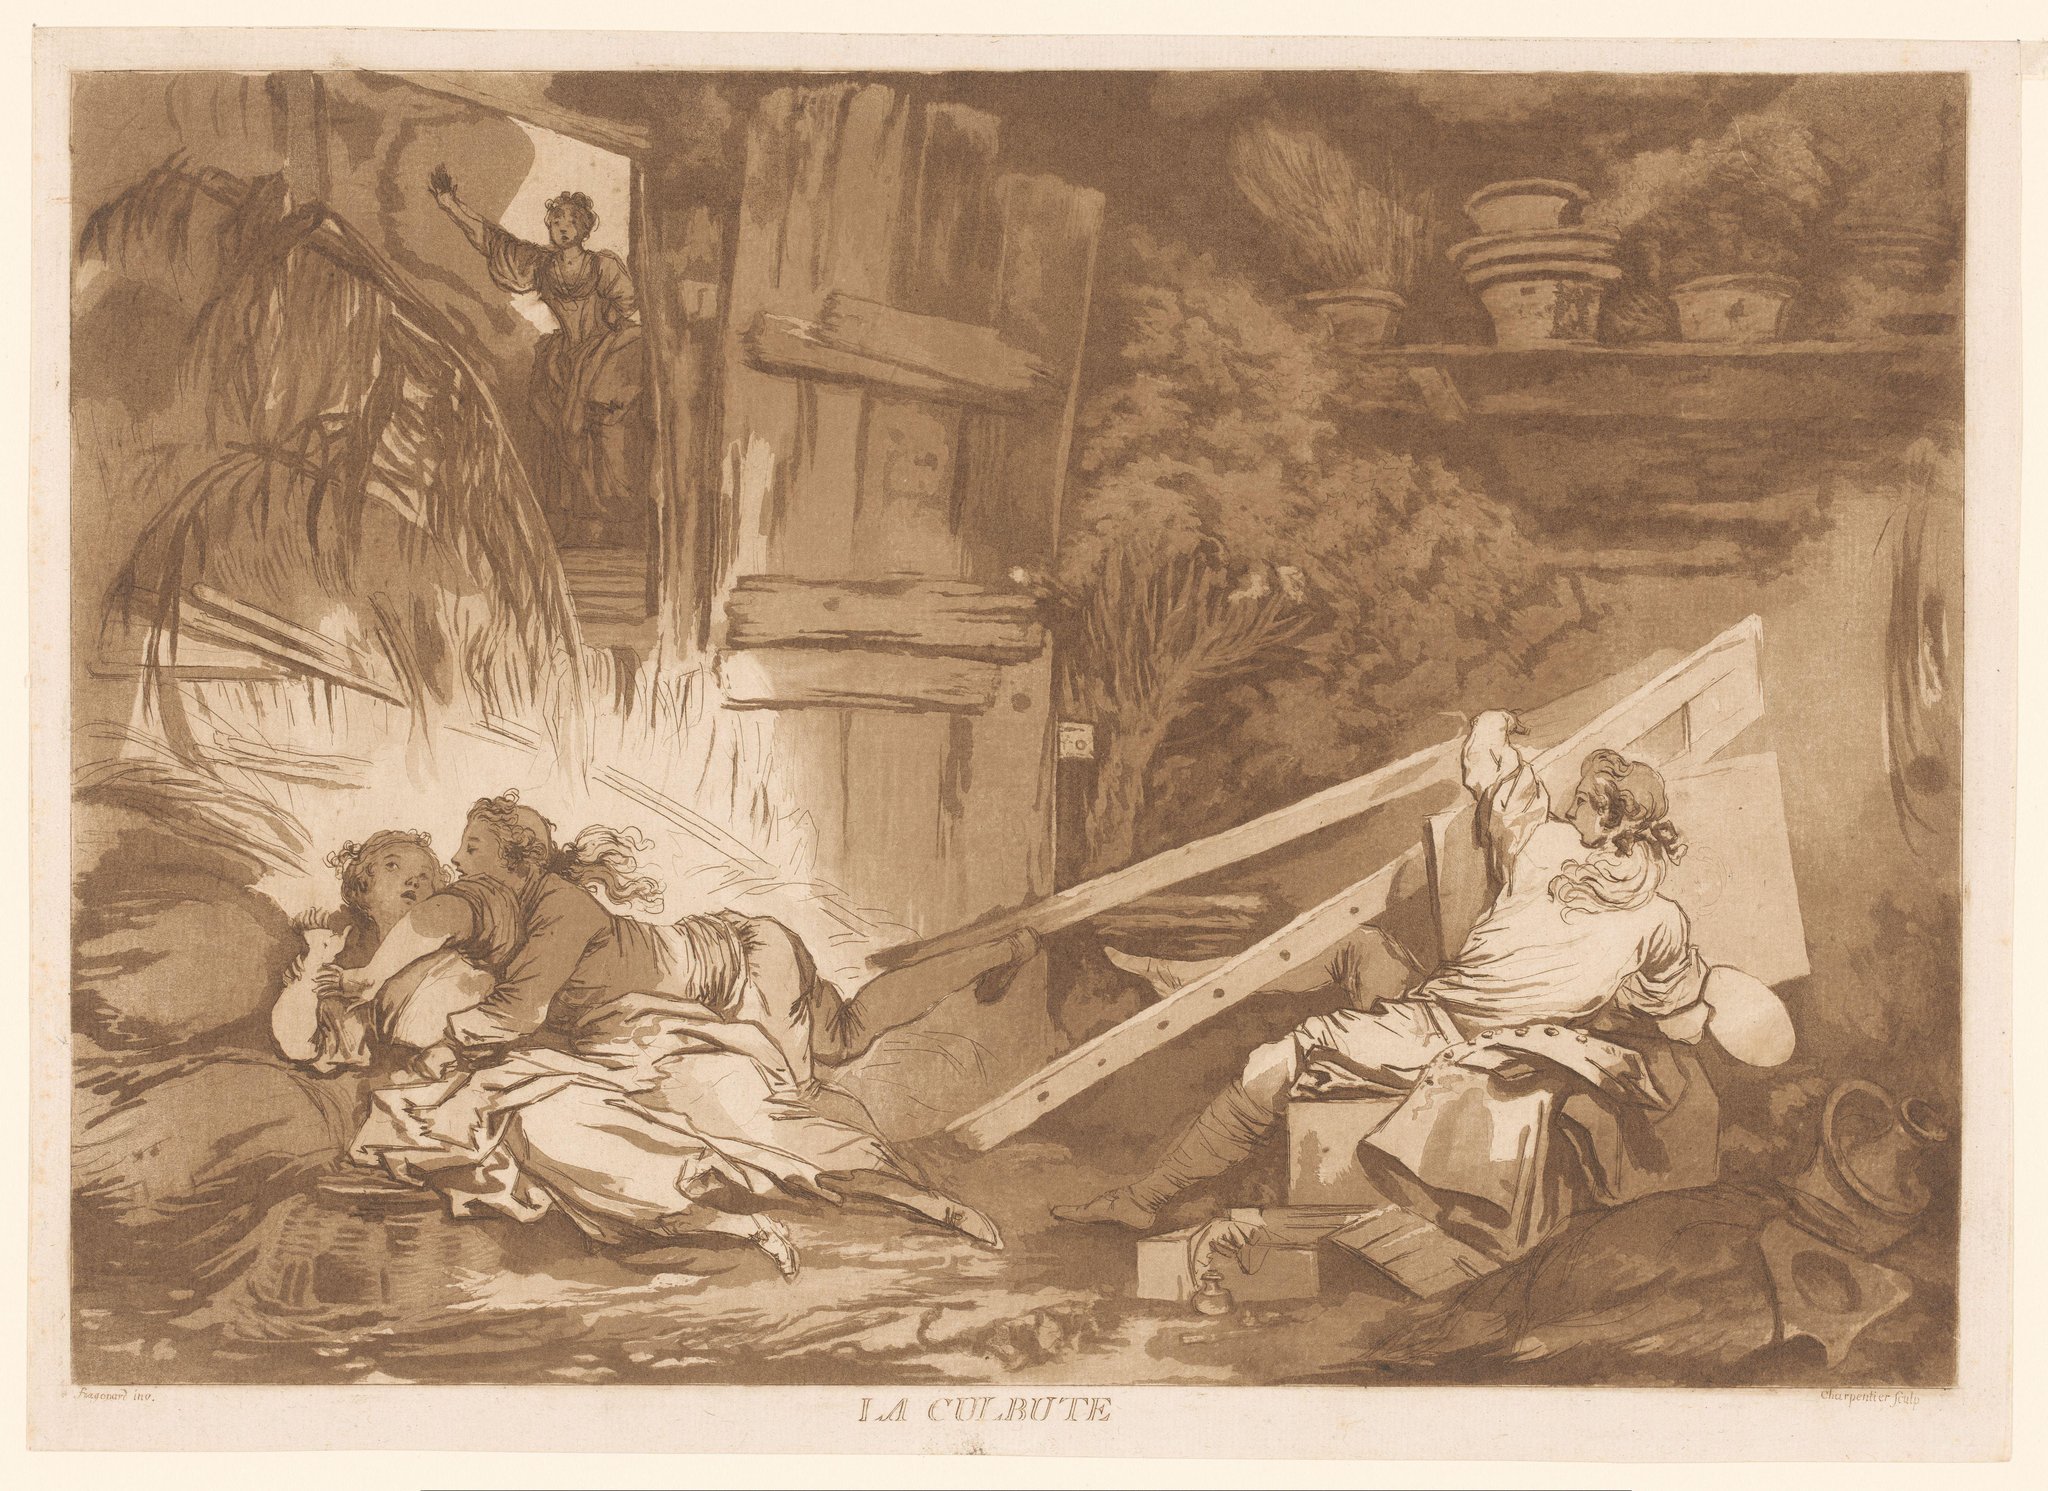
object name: print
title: Jonge struikelende man valt op een vrouw die wordt geschilderd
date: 1766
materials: paper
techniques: aquatint, etching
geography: france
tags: model, sitter ~ painting - cc - out of doors, falling, easel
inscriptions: collector's mark: Lugt 240